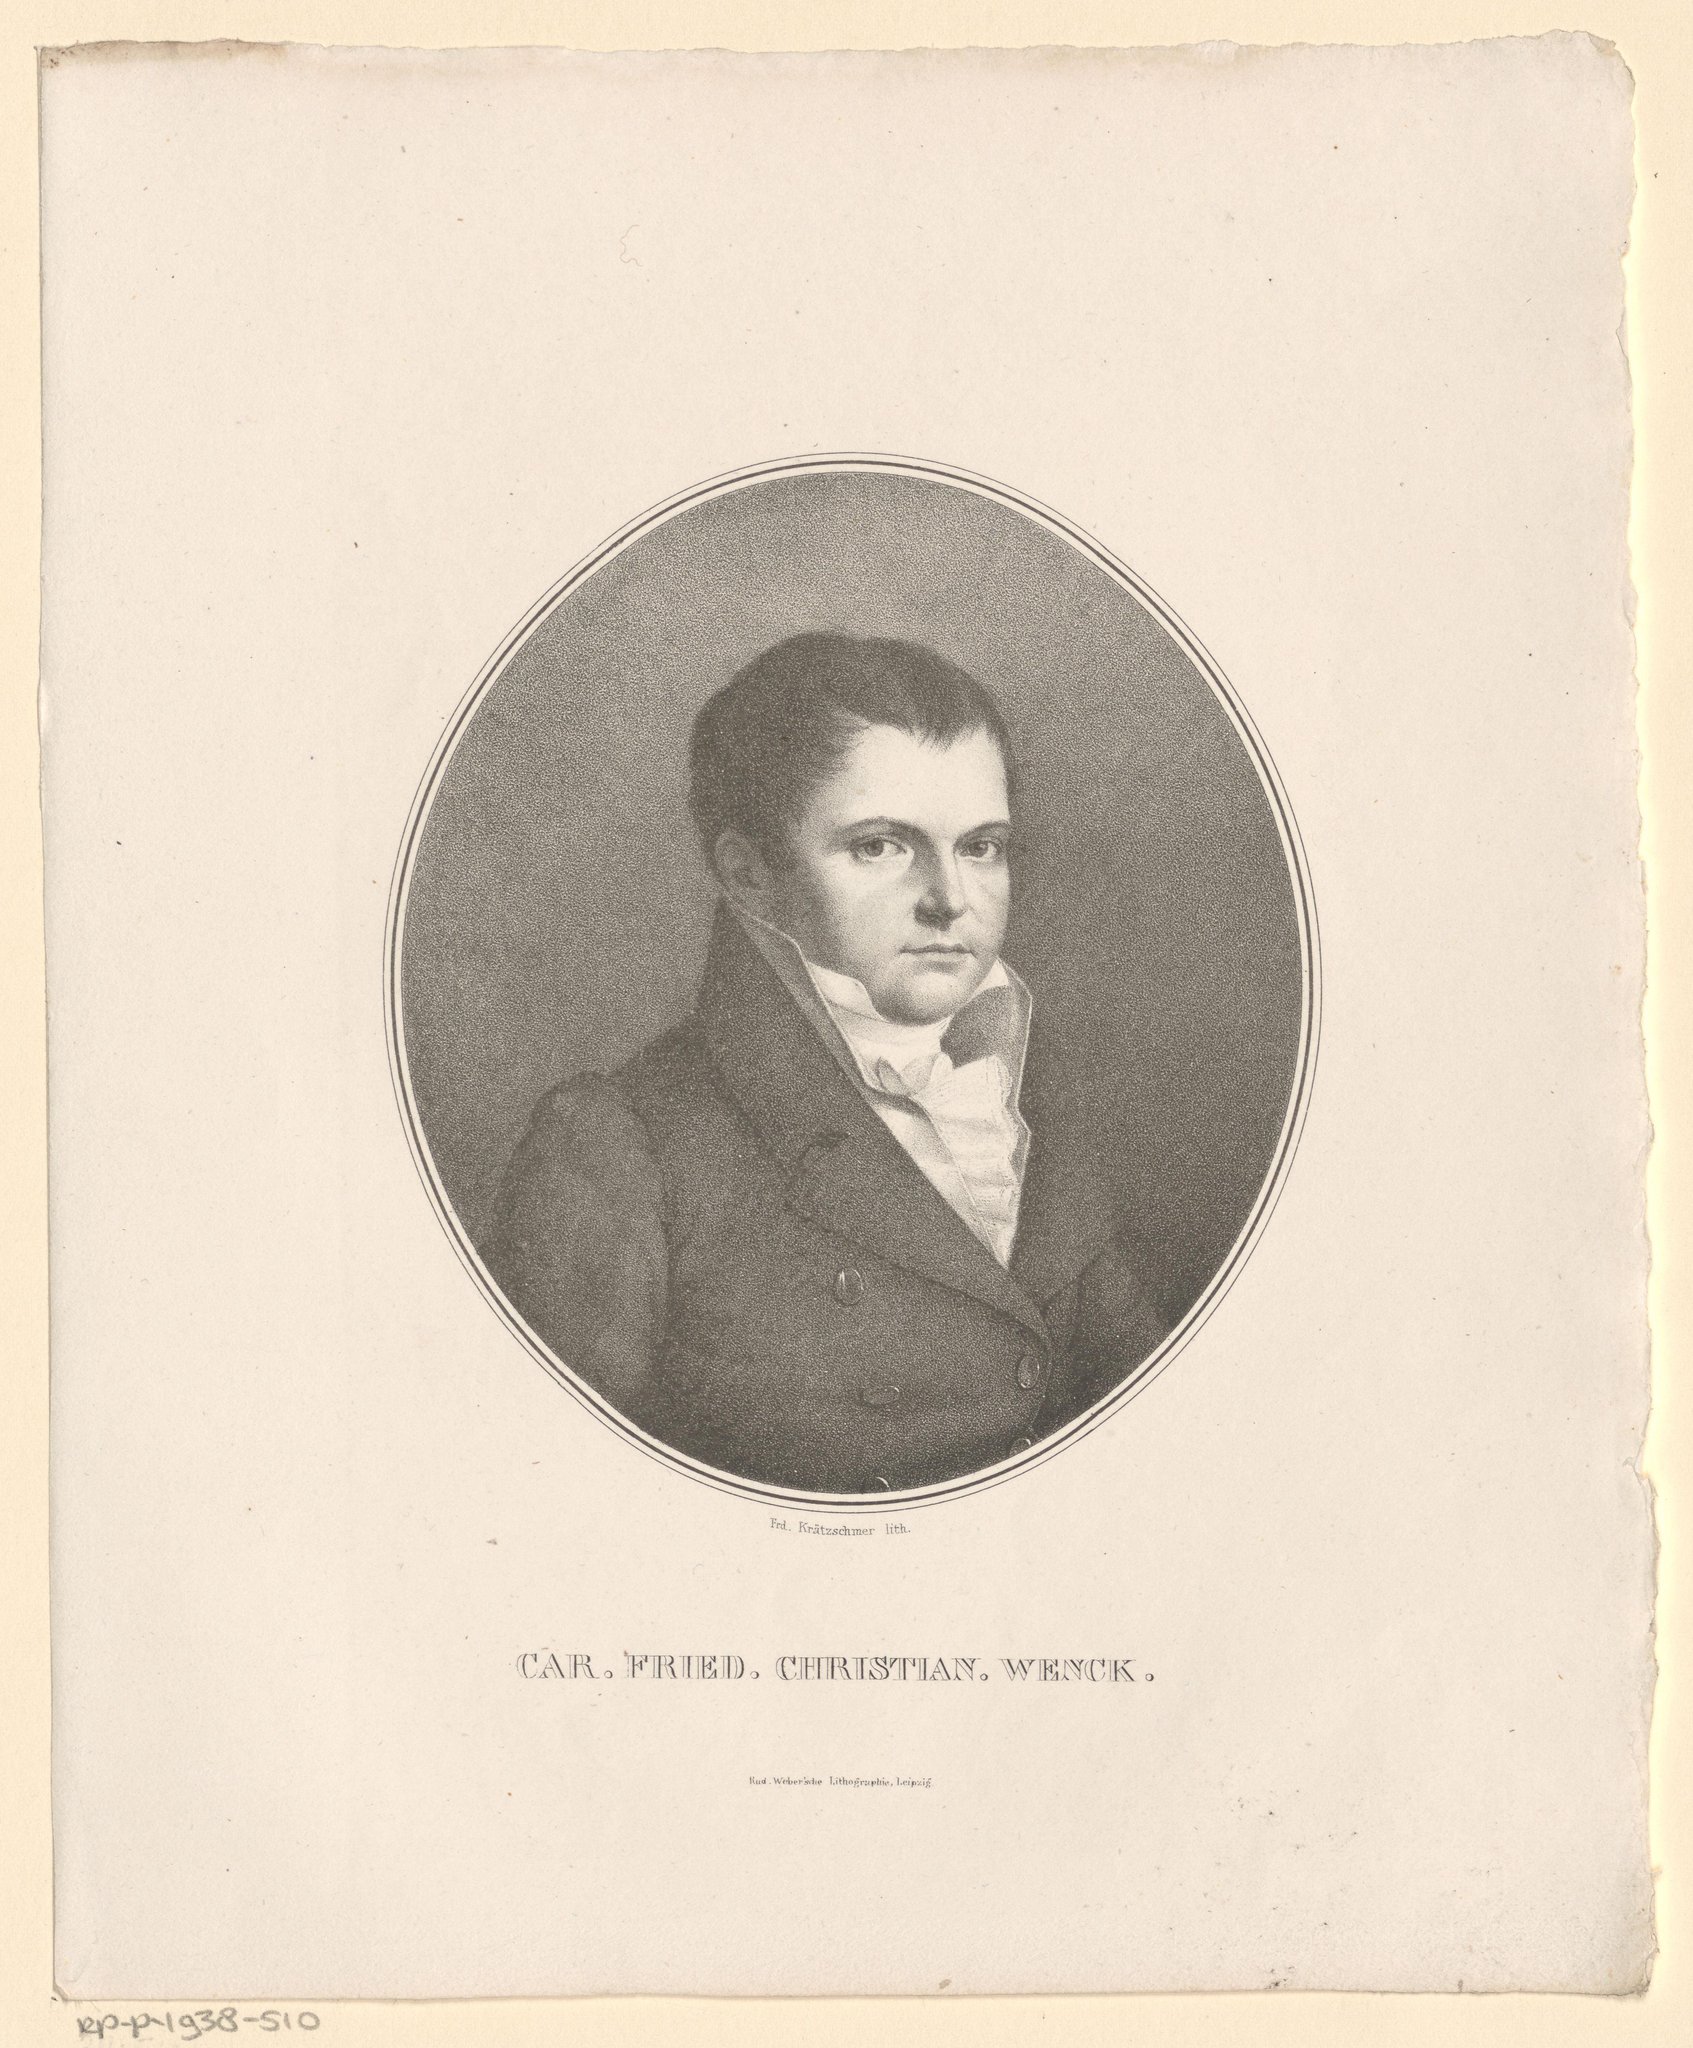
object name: print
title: Portret van Karl Friedrich Christian Wenck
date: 1816-1886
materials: paper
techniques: lithograph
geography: leipzig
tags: historical persons, lawyer, attorney at law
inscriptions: collector's mark: Lugt 2228